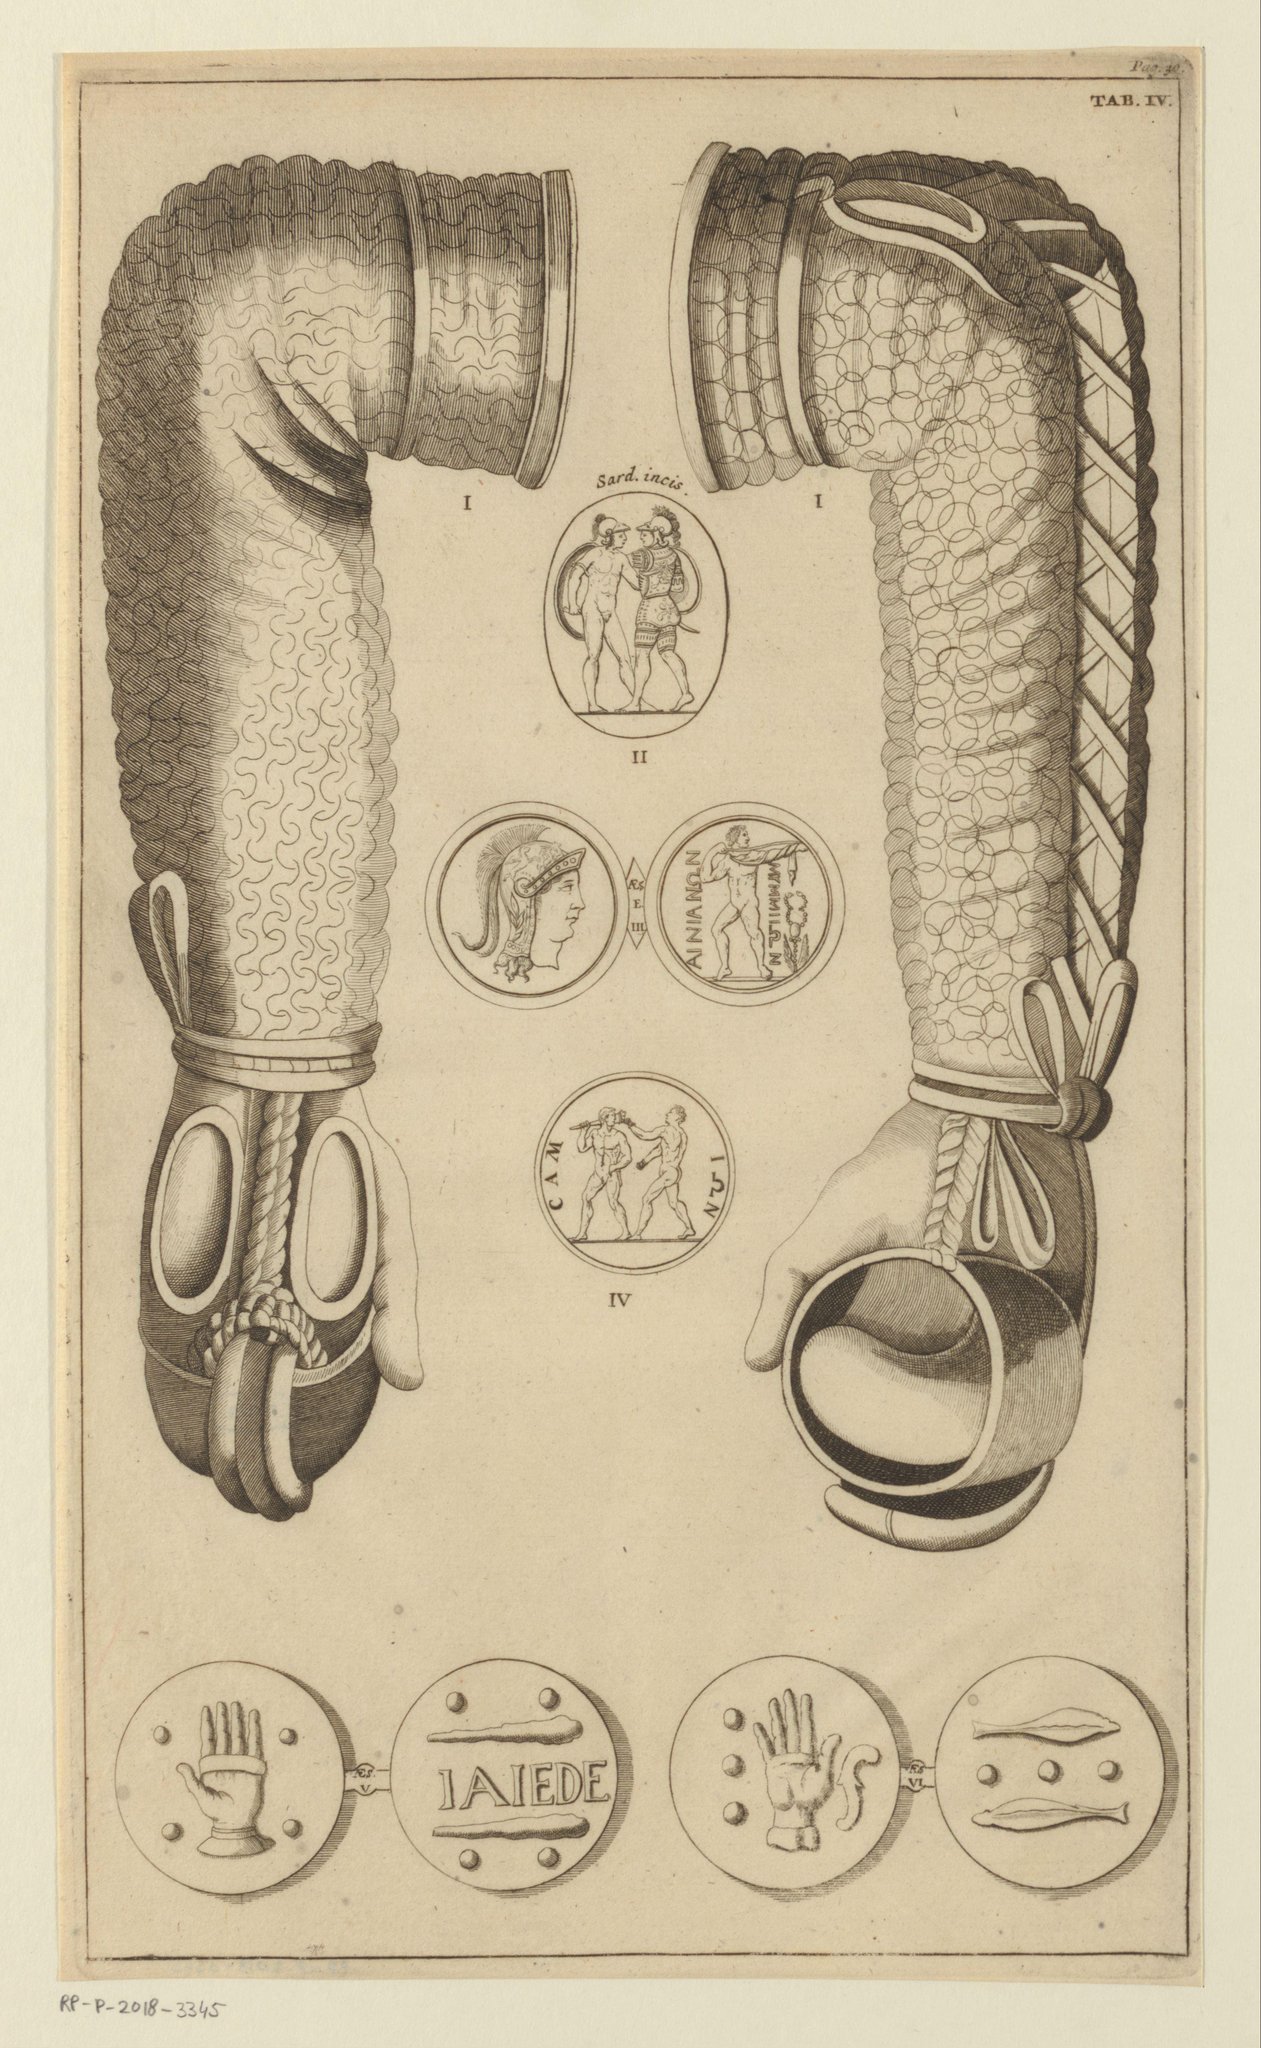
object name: print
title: Compositie met twee armen, munten en een gem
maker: Anonymous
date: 1700-1799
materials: paper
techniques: engraving, etching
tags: arms, coin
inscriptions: collector's mark: Lugt 2228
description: Prent uit een onbekend boek met objecten, kunstwerken en figuren uit de Romeinse geschiedenis en religie. Dit betreft een illustratie bij p. 30.